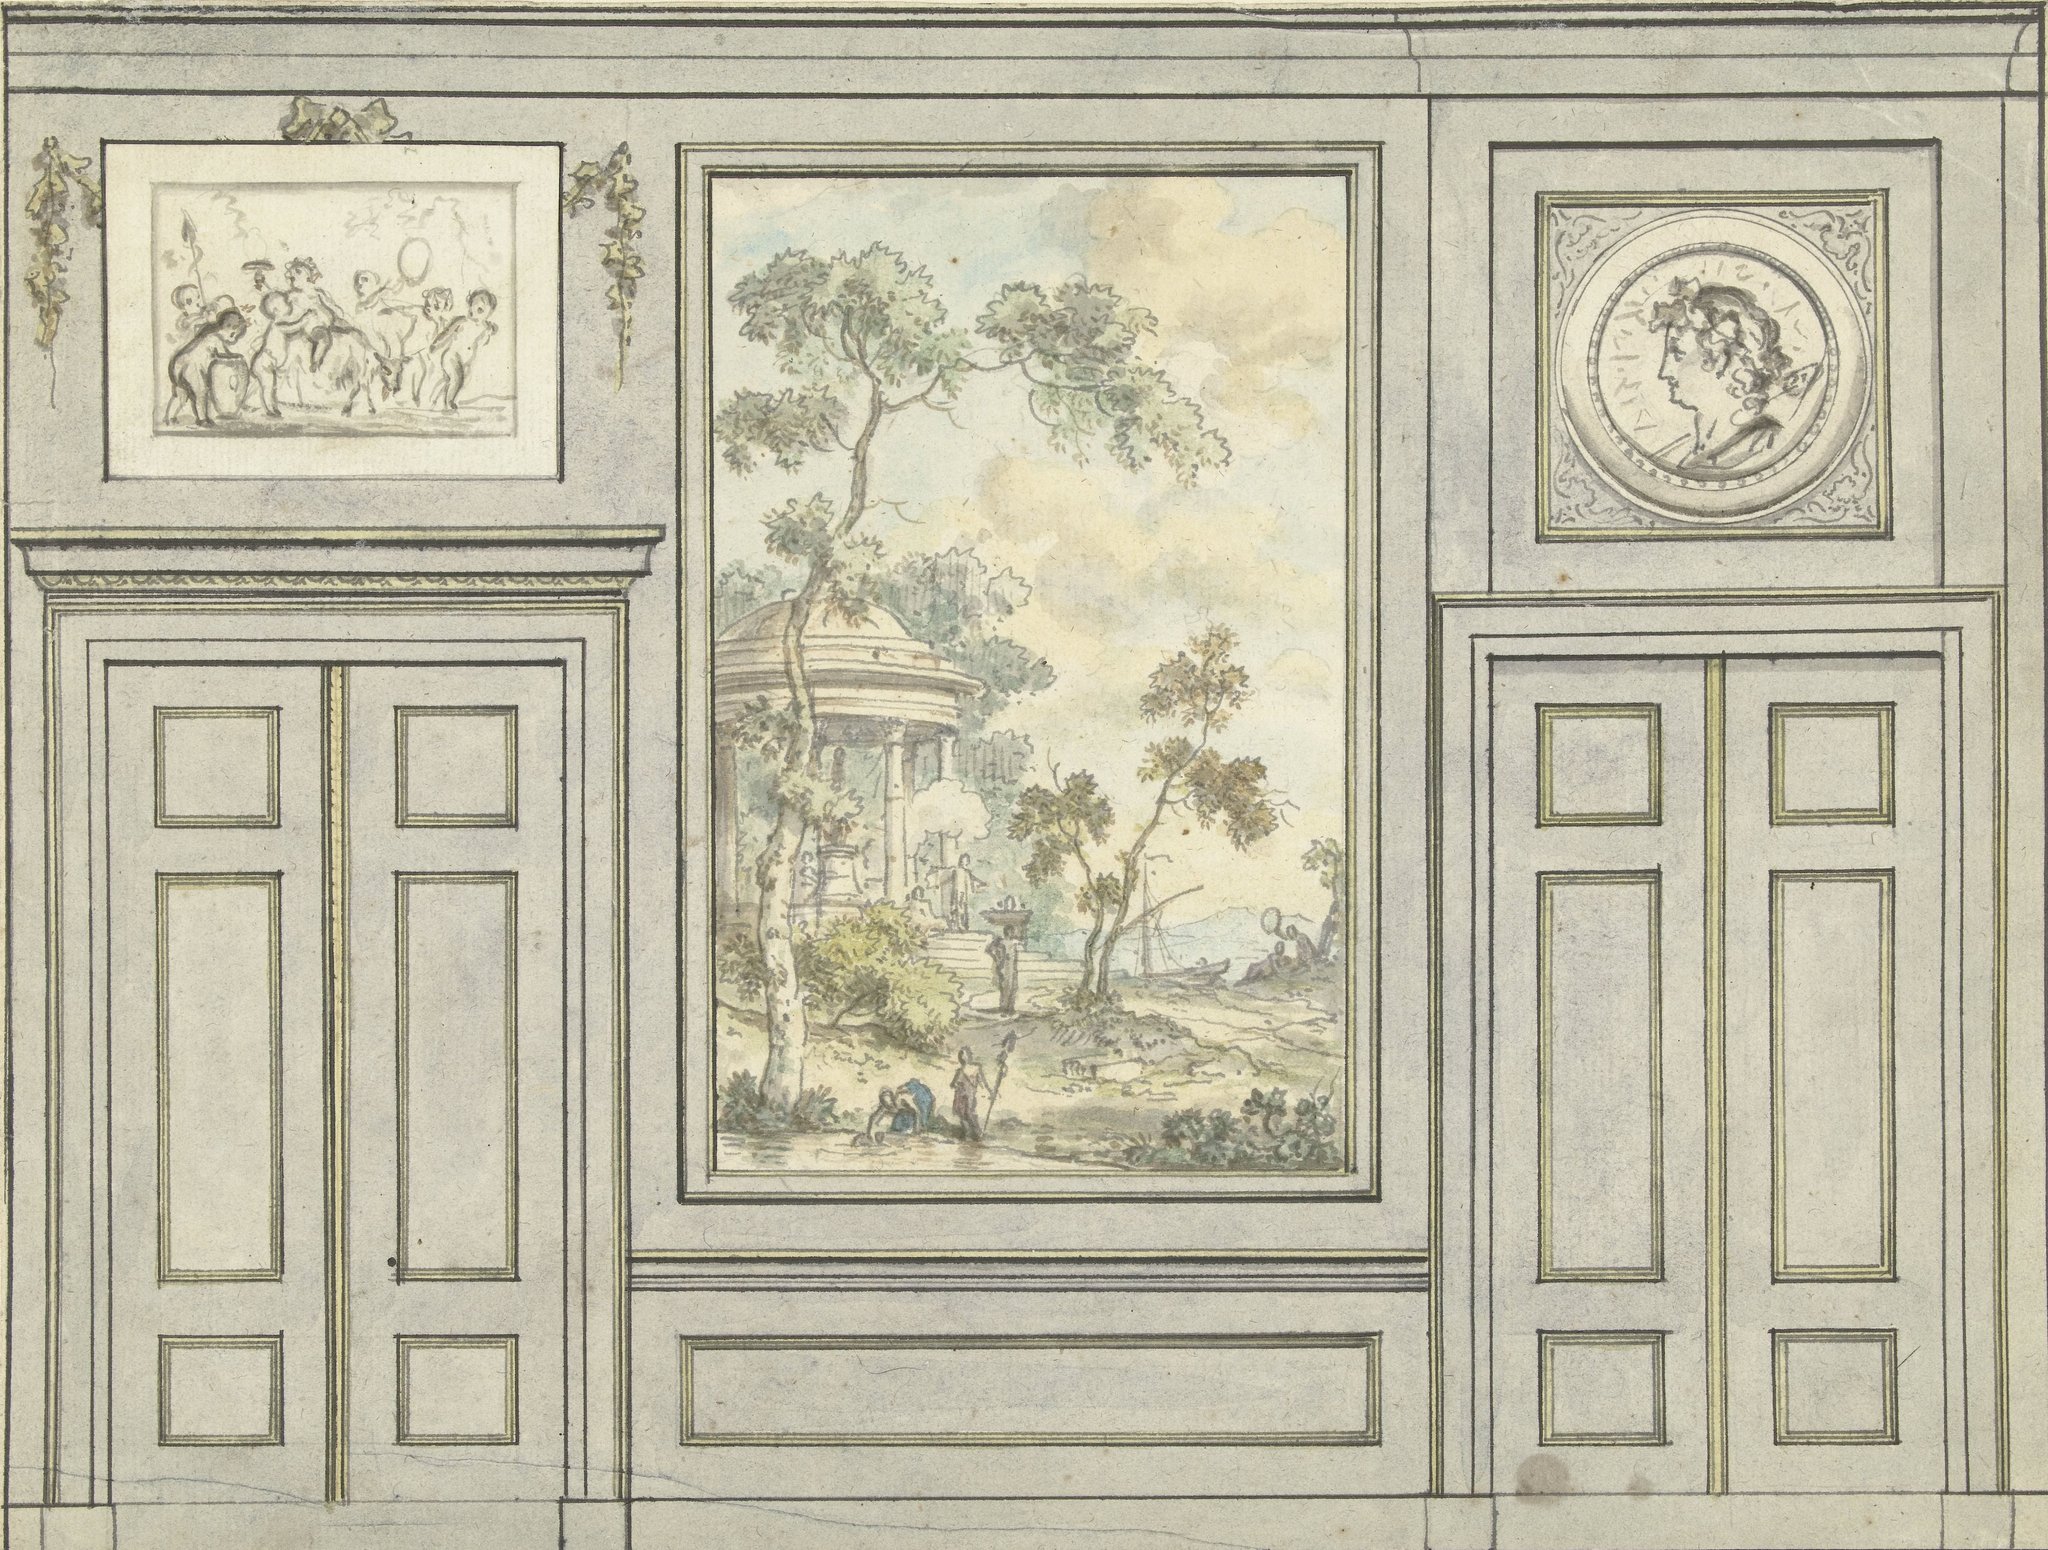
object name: watercolor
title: Ontwerp voor kamerwand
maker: jurriaan andriessen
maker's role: draughtsman, painter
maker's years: 1742-1819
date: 1752-1819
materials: graphite, ink, paper, watercolor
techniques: brush, pen